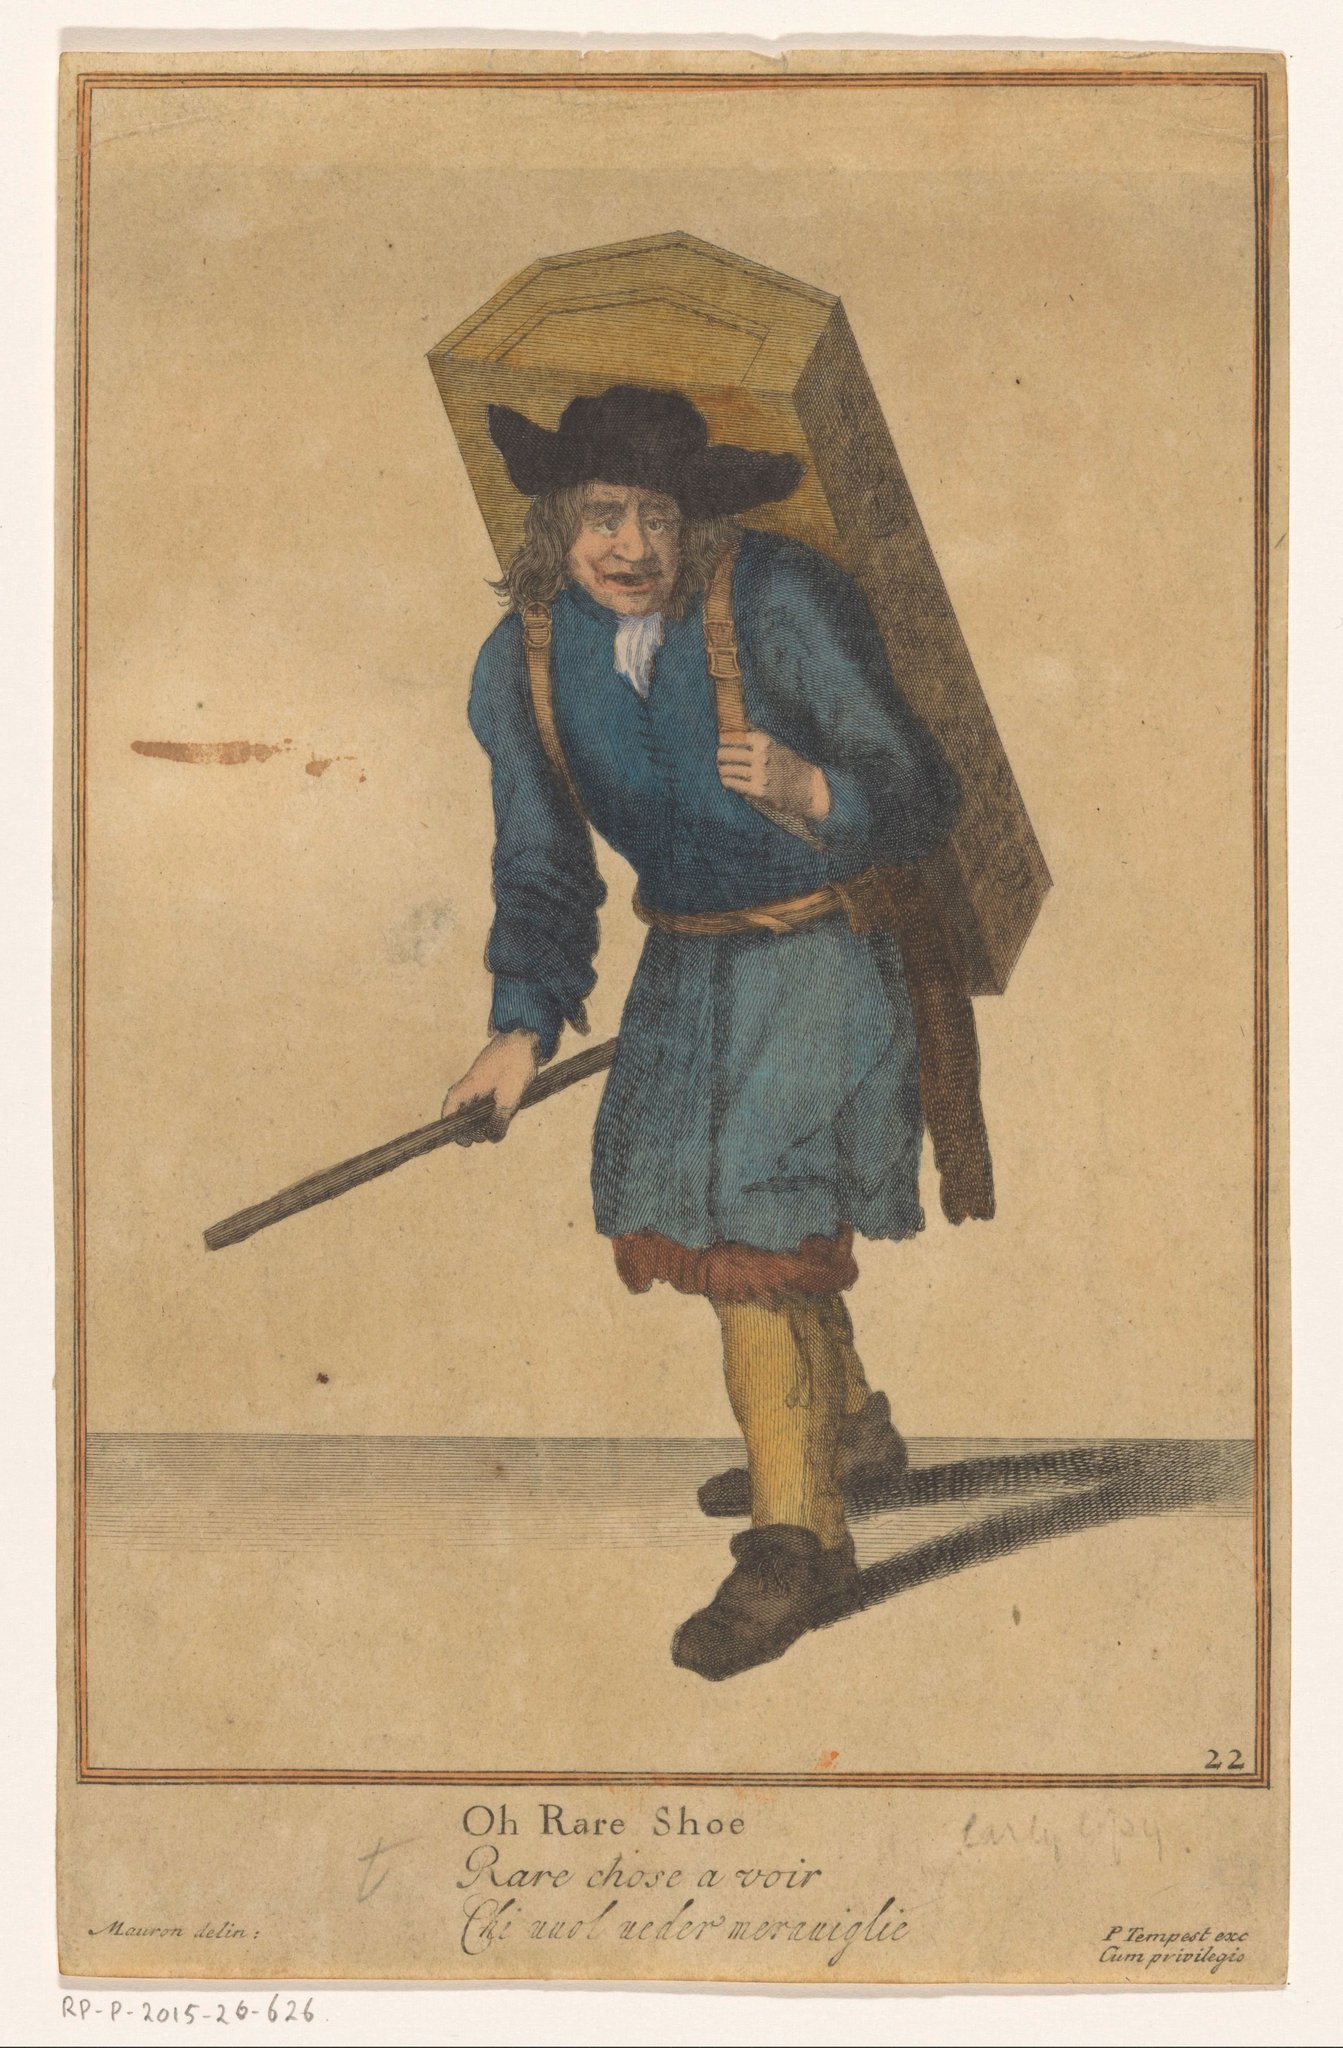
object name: print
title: The Cryes of the City of London Drawne after the Life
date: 1688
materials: paper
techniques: engraving, etching, hand coloring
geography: london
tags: peep-show, 'cris de paris', cries of london, etc.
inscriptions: collector's mark: Lugt 4779, watermark, collector's mark: Lugt 2228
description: Voor het eerst gepubliceerd in 1688. Waarschijnlijk is is deze prent afkomstig uit een latere editie, mogelijk uitgegeven door Henry Overton I.